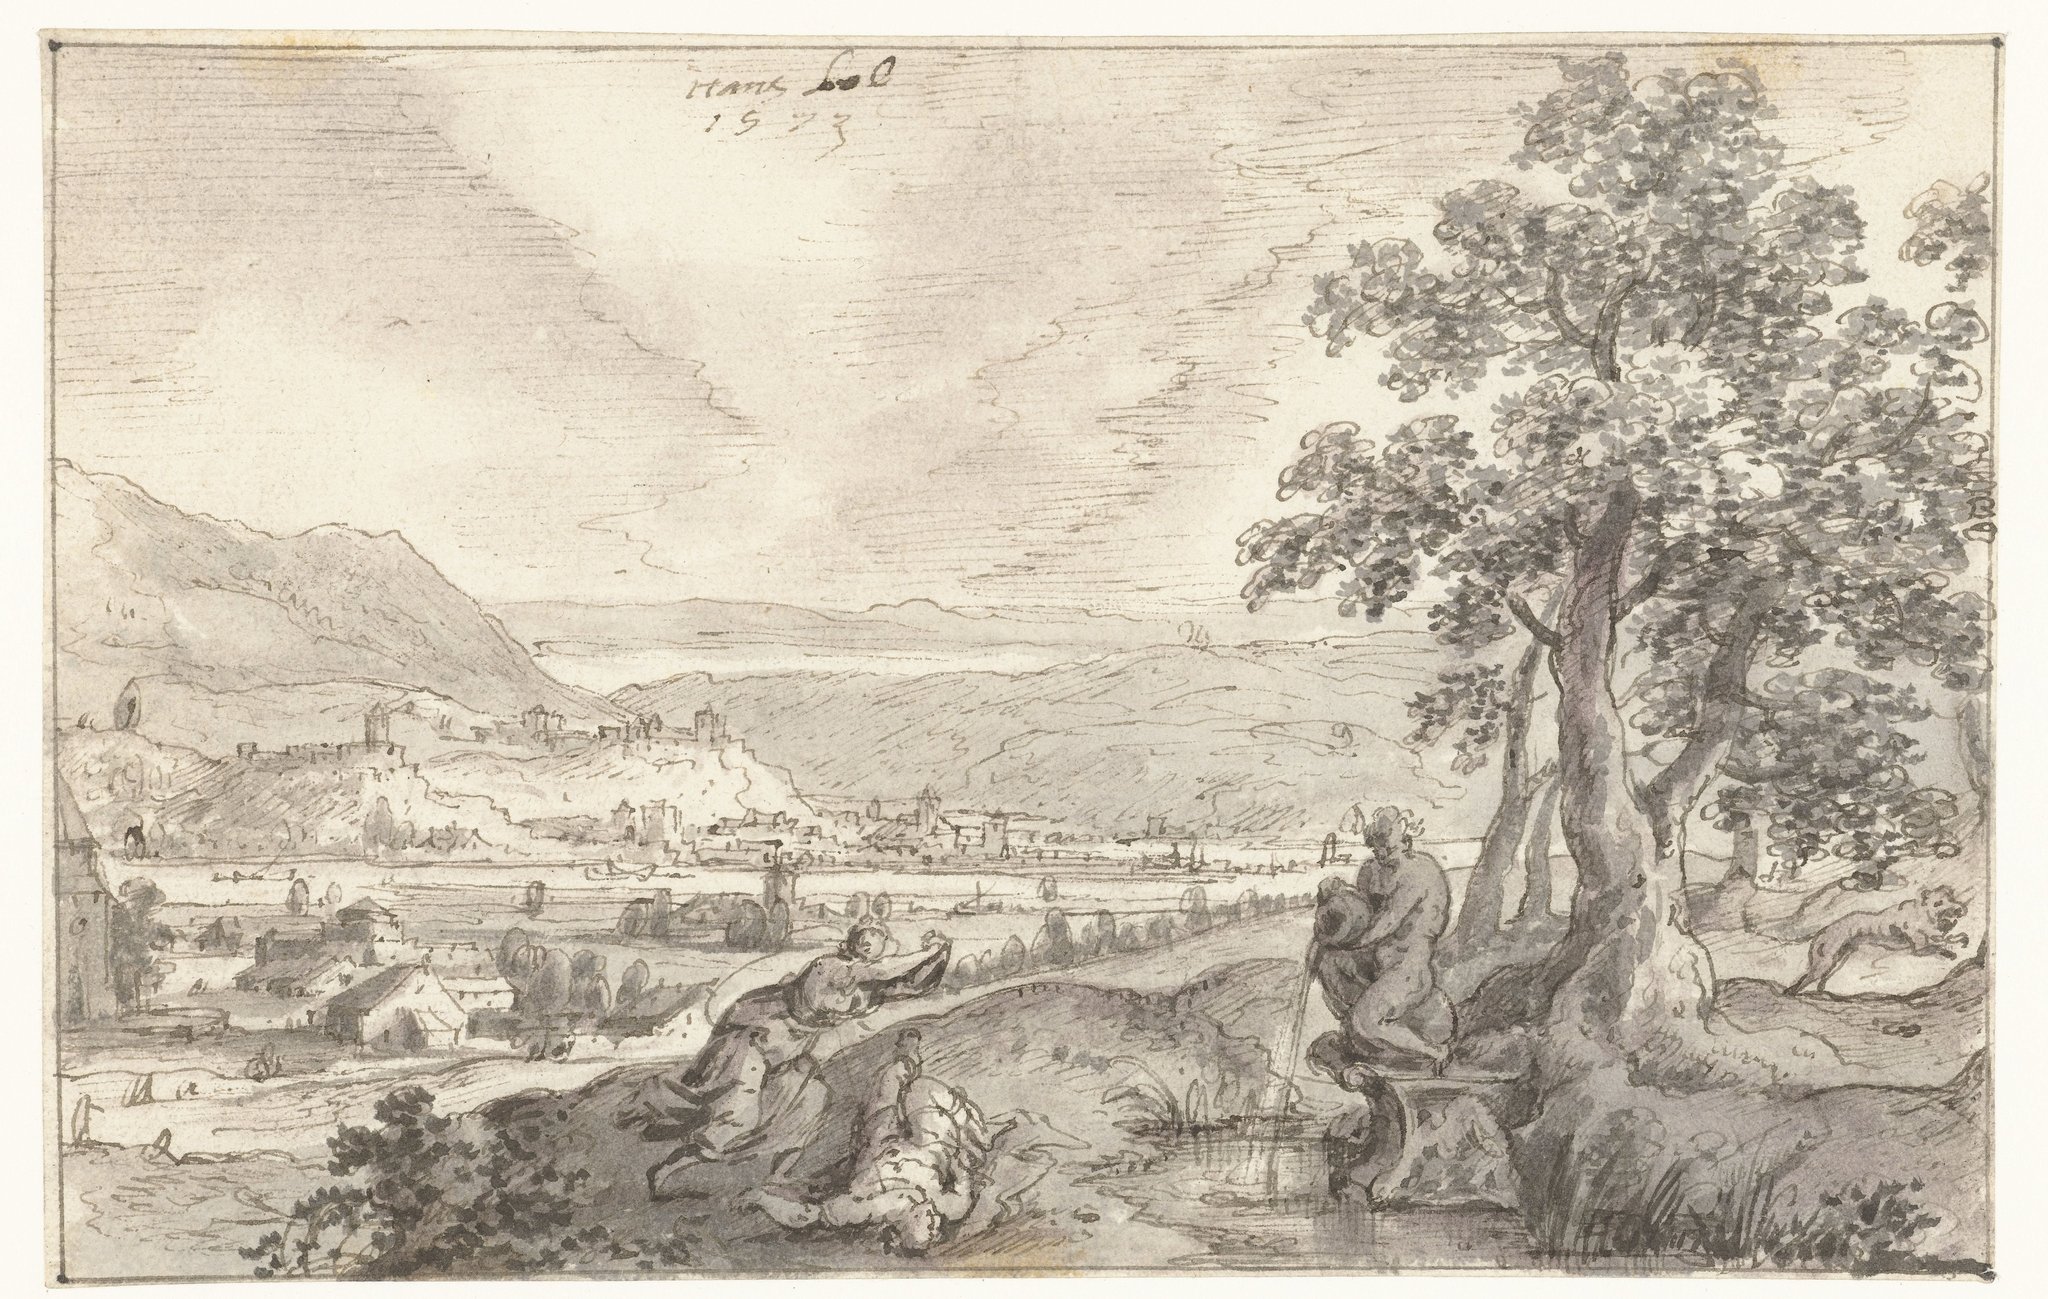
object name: drawing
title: Pyramus en Thisbe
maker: hans bol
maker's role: draughtsman, print maker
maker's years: 1534-1593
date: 1573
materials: ink, paper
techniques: brush, pen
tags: (high) hill, thisbe discovers the dying pyramus (the scene may be represented near a fountain)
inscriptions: date